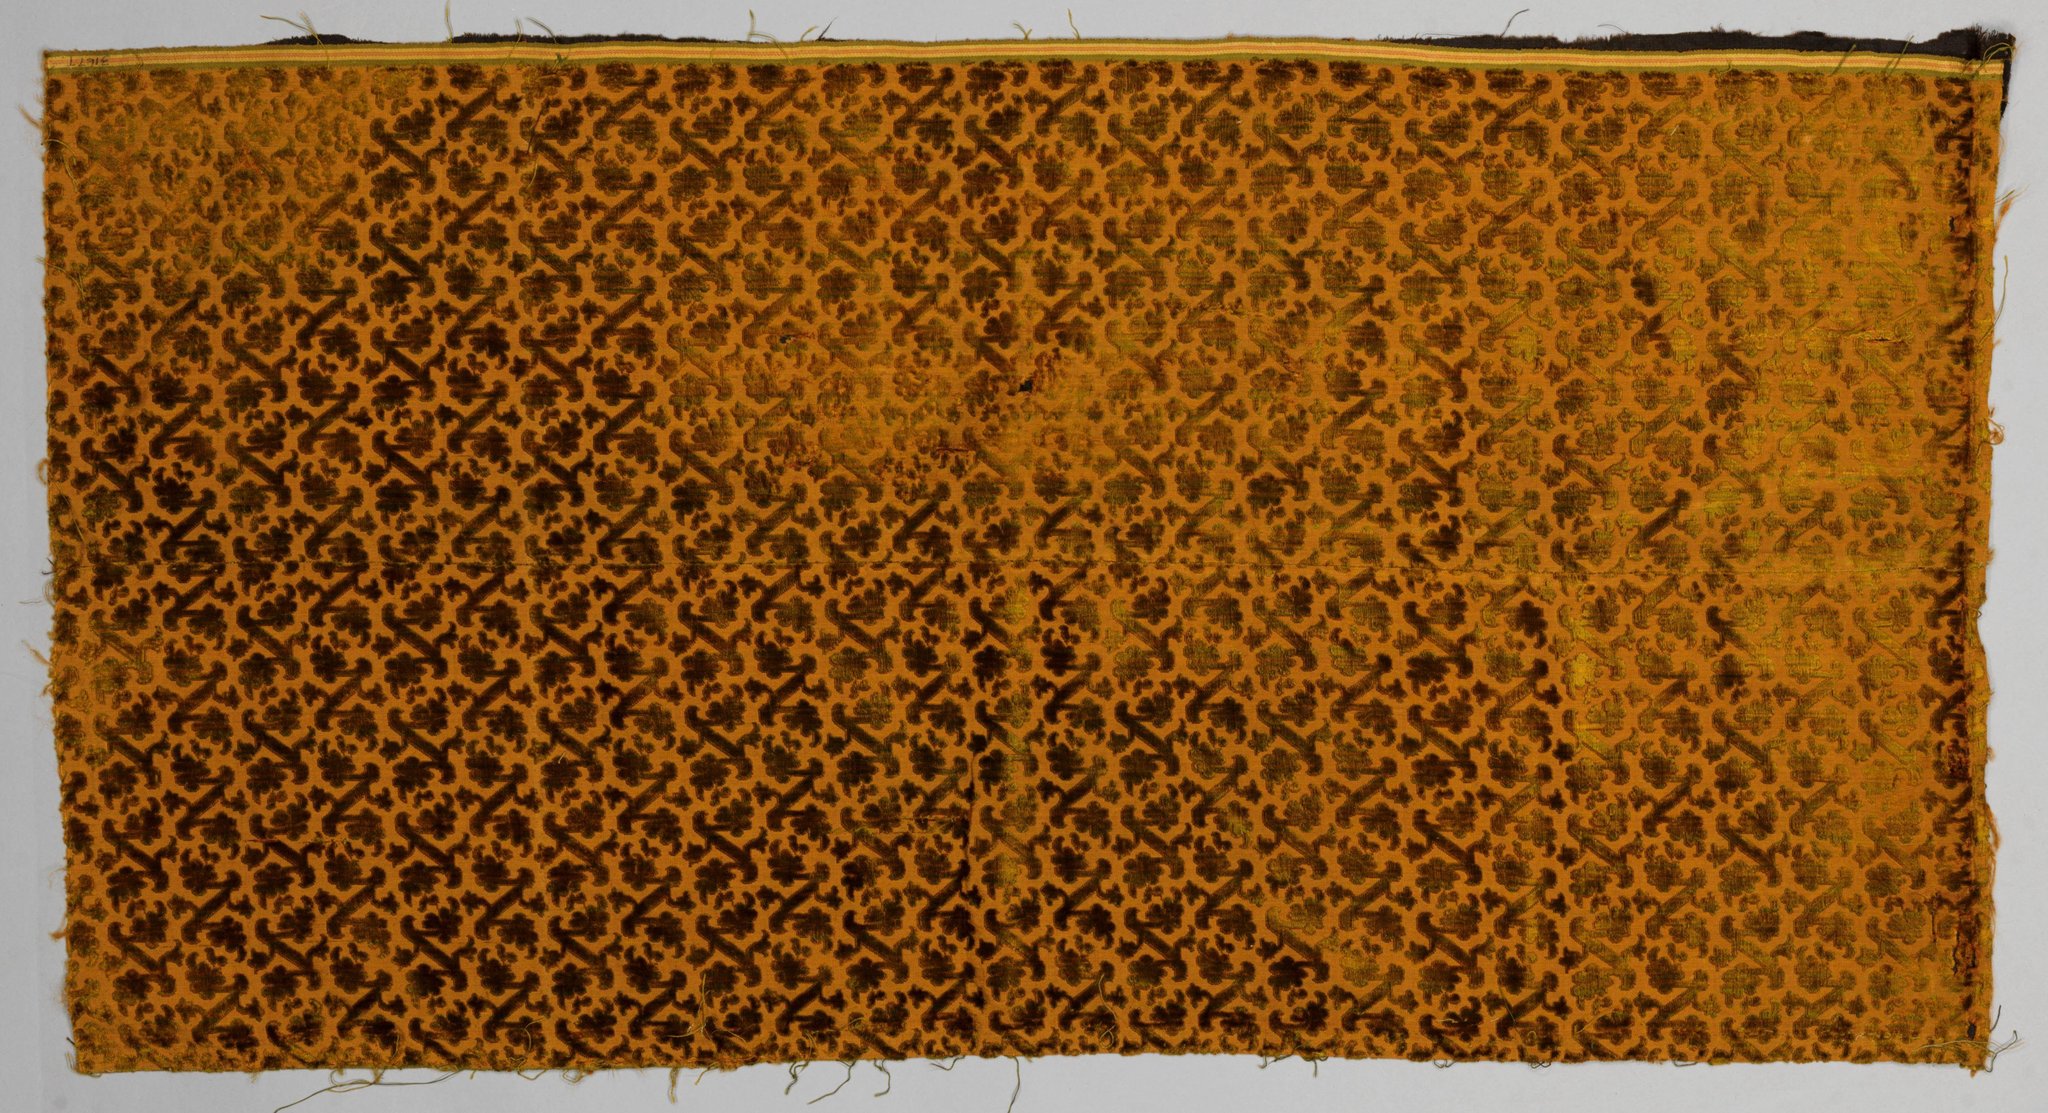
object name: baan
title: Baan zijde, samengesteld uit twee stukken met zelfkanten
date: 1600-1625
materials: silk, velvet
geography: italy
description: Baan zijde, samengesteld uit twee stukken met zelfkanten. Dessin: in rijen geplaatste en om en om van richting wisselende dwarsbalken met omhoog stijgende en afhangende gelobde bladeren en klokvormige bloemen in goudgeel en groen op een goudgeel fond. Gevoerd met donkerbruin linnen in platbinding. Op de zelfkant het nummer: 31677. Op achterzijde in blauw geschreven: A1/575,-. Opgespeld papier waarop de letters AA. Toestand: redelijk goed.